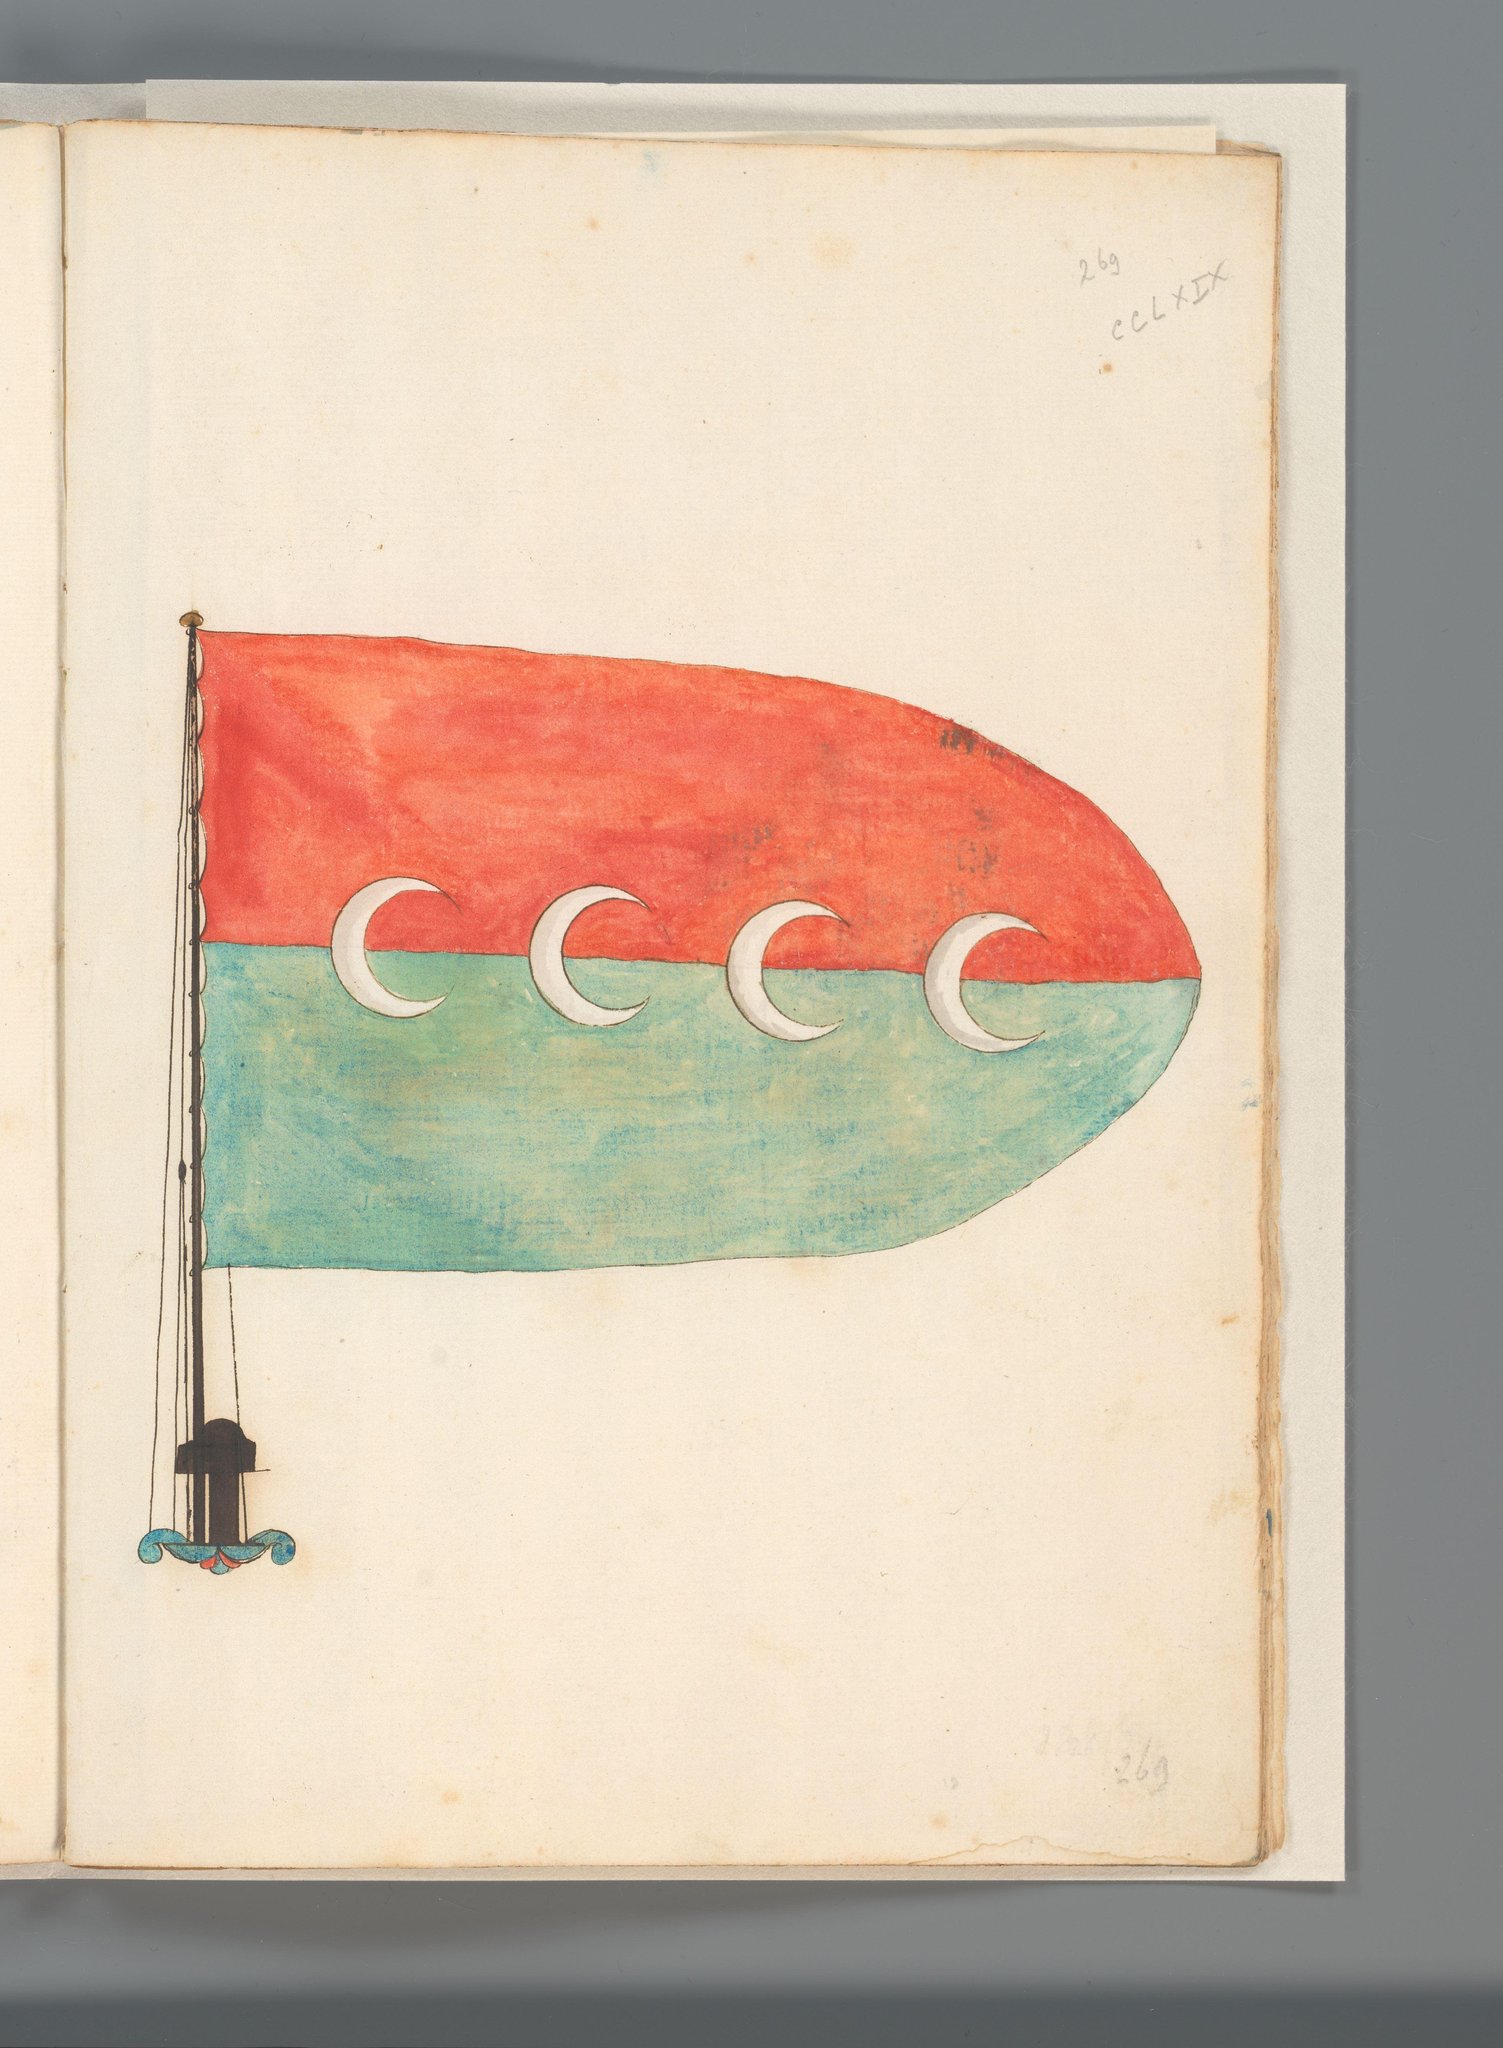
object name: drawing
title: Vlag van Istanboel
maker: Anonymous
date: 1667-1670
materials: ink, paper, watercolor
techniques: brush, pen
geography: france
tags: flag, colours (as symbol of the state, etc.)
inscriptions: number: ‘269 / CCLXIX / 269’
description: Vlag (mogelijk) van Istanboel. Vlag met twee horizontale banen in rood en groen waarop vier halve manen, met afgeronde vluchtzijde. Vlag op vlaggensteng en mastvoet. Afgebeeld op folio 135r. Onderdeel van een vlaggenboek met vlaggen uit Europa, Noord-Afrika, Nabije en Verre Oosten.